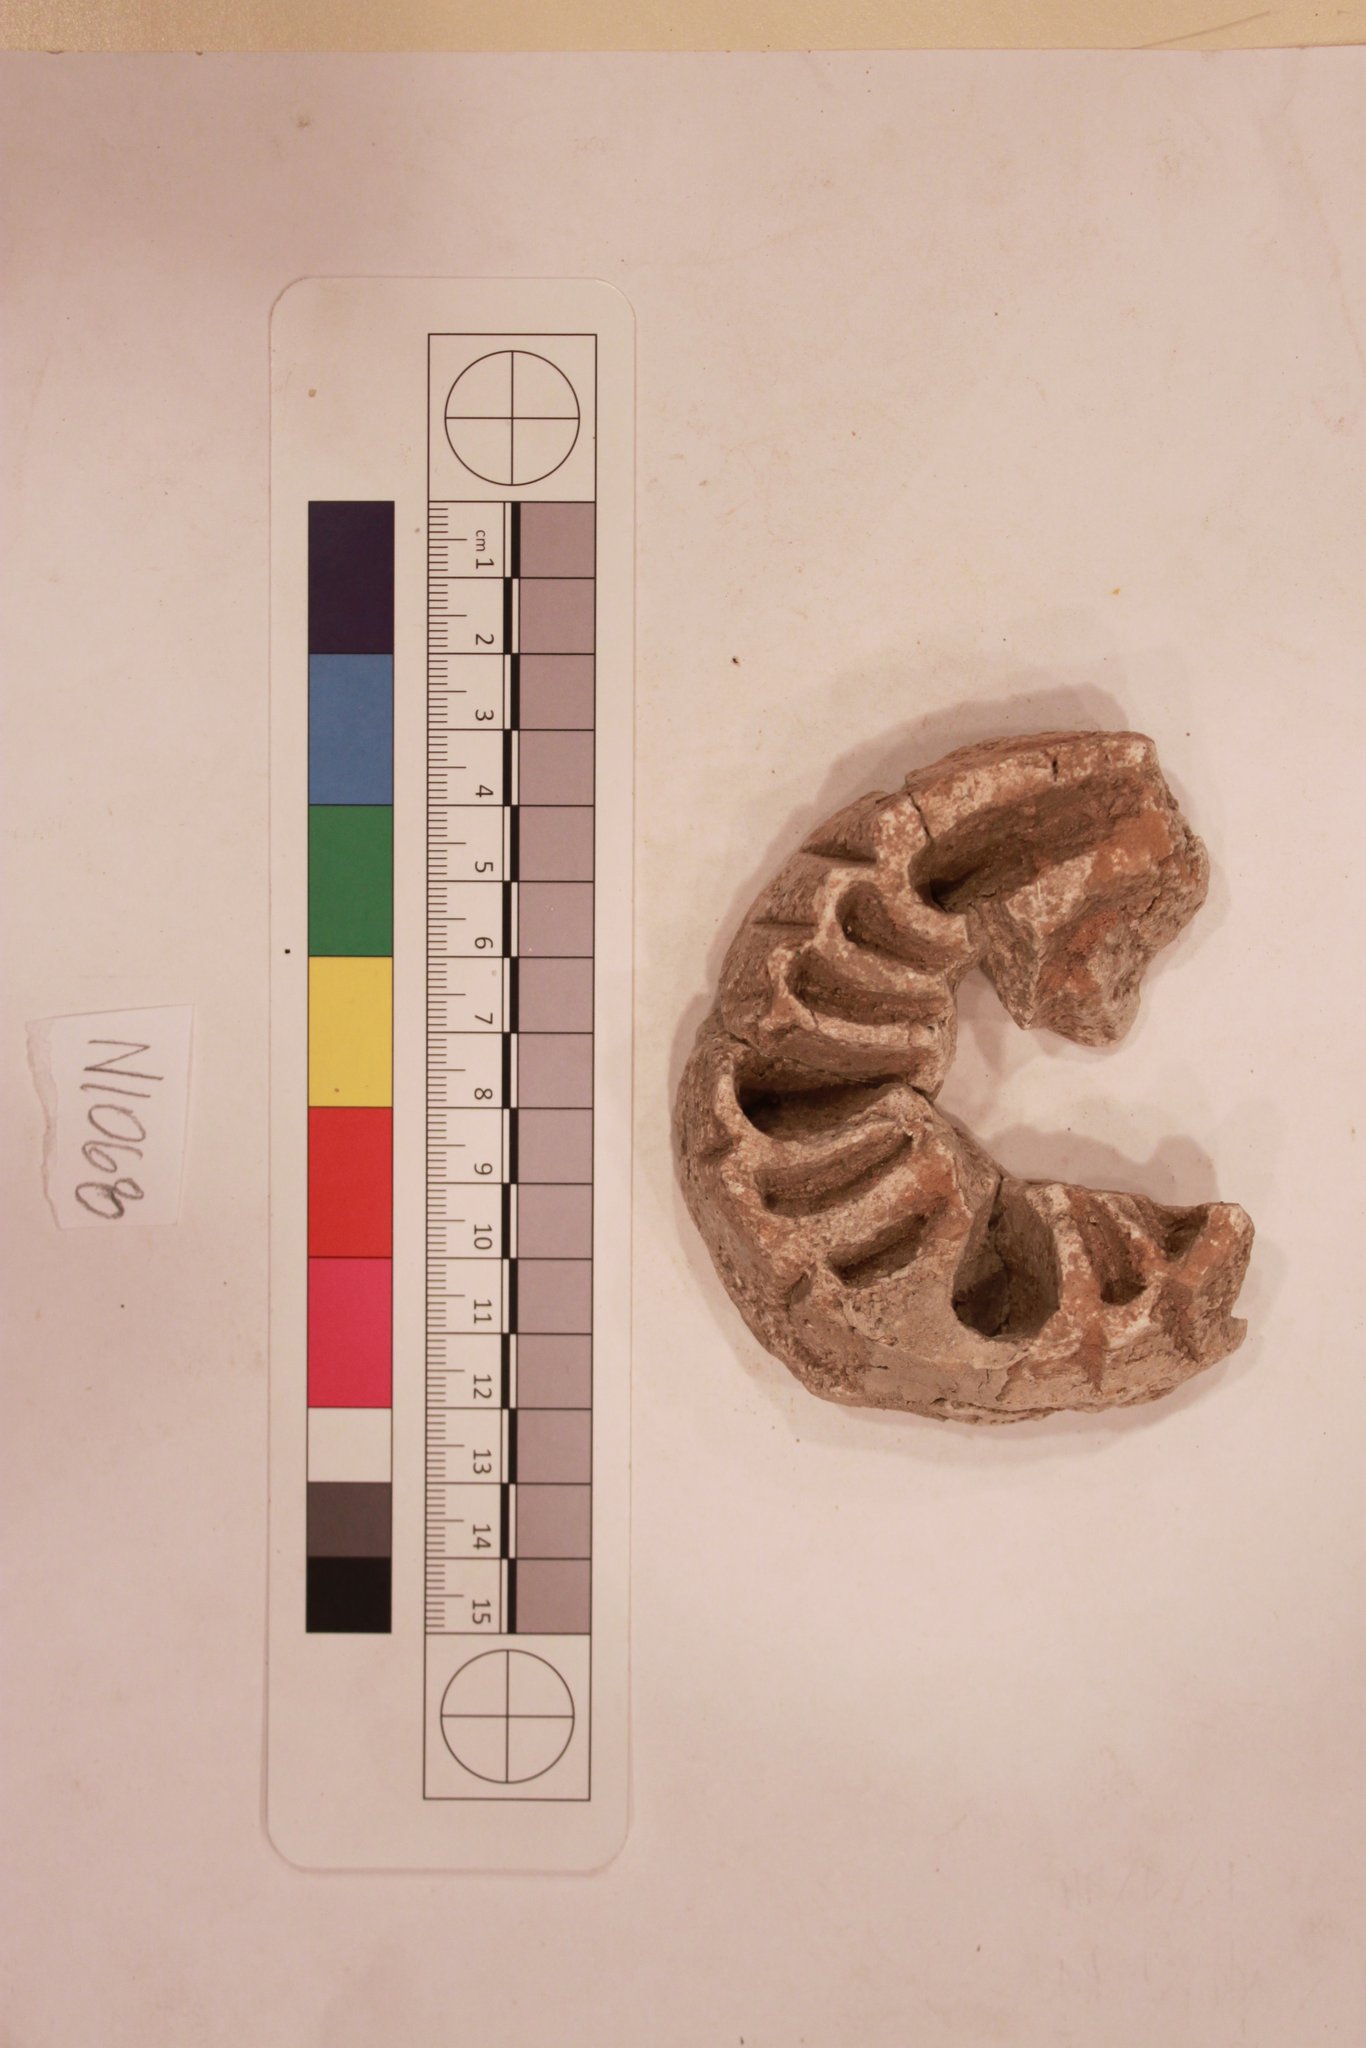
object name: fragment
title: Stucco Fragment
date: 701-1200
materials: plaster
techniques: carving, painting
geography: iran